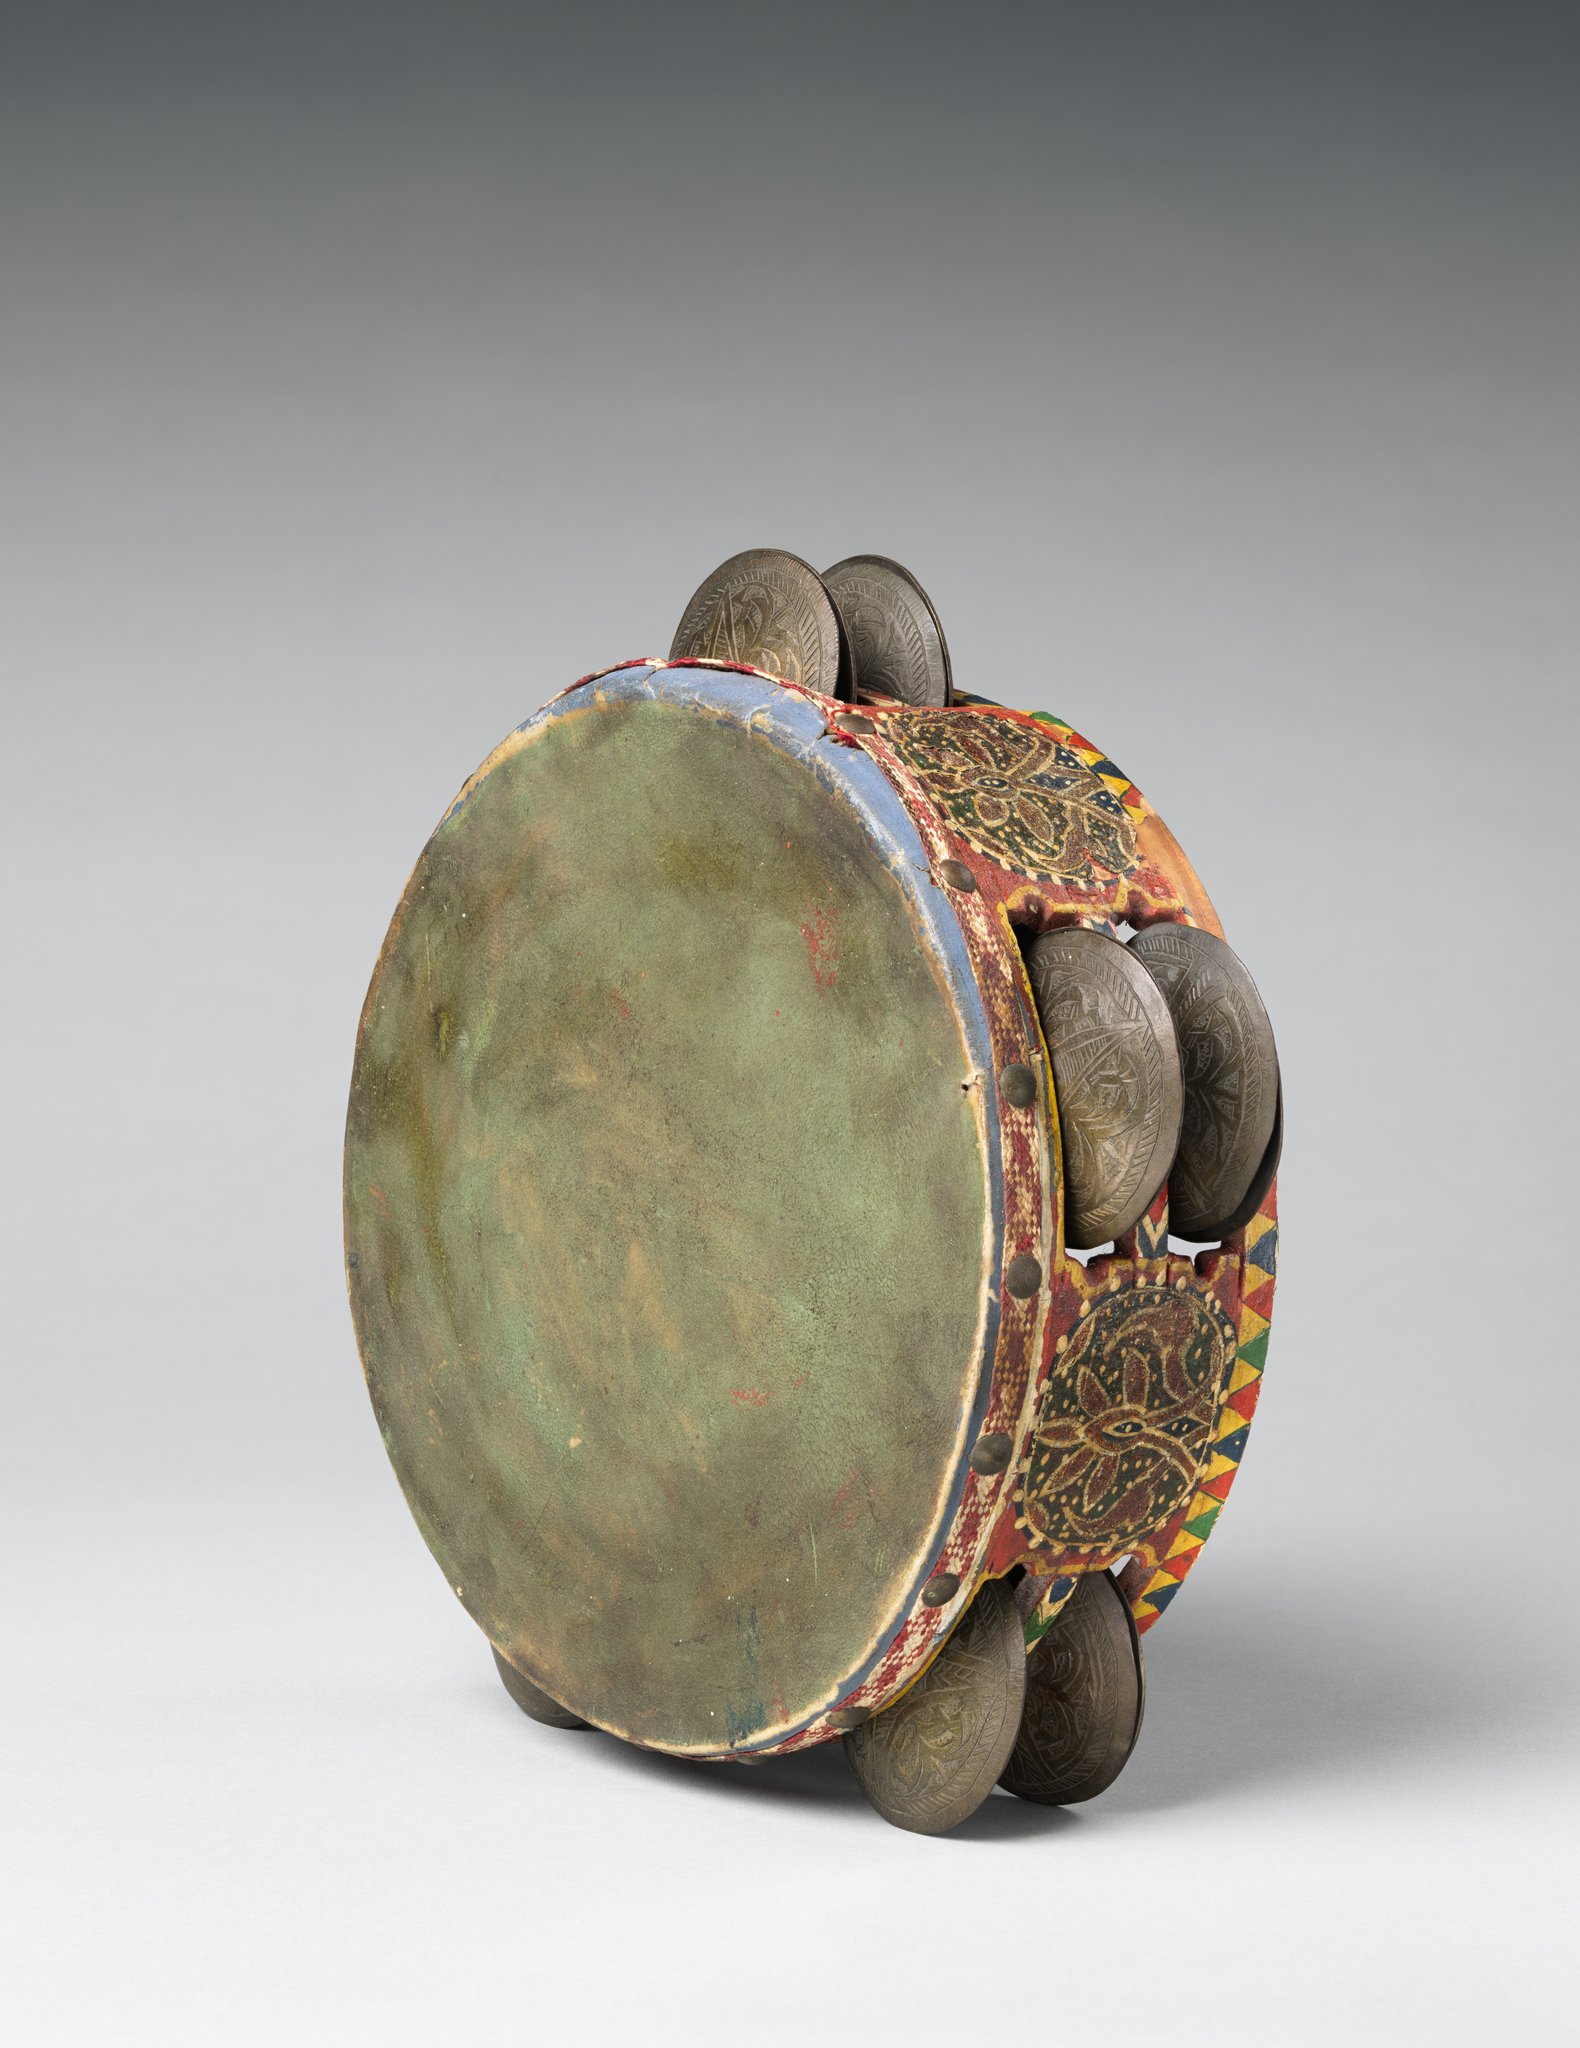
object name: tar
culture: moroccan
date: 1867-1900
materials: skin, wood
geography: morocco